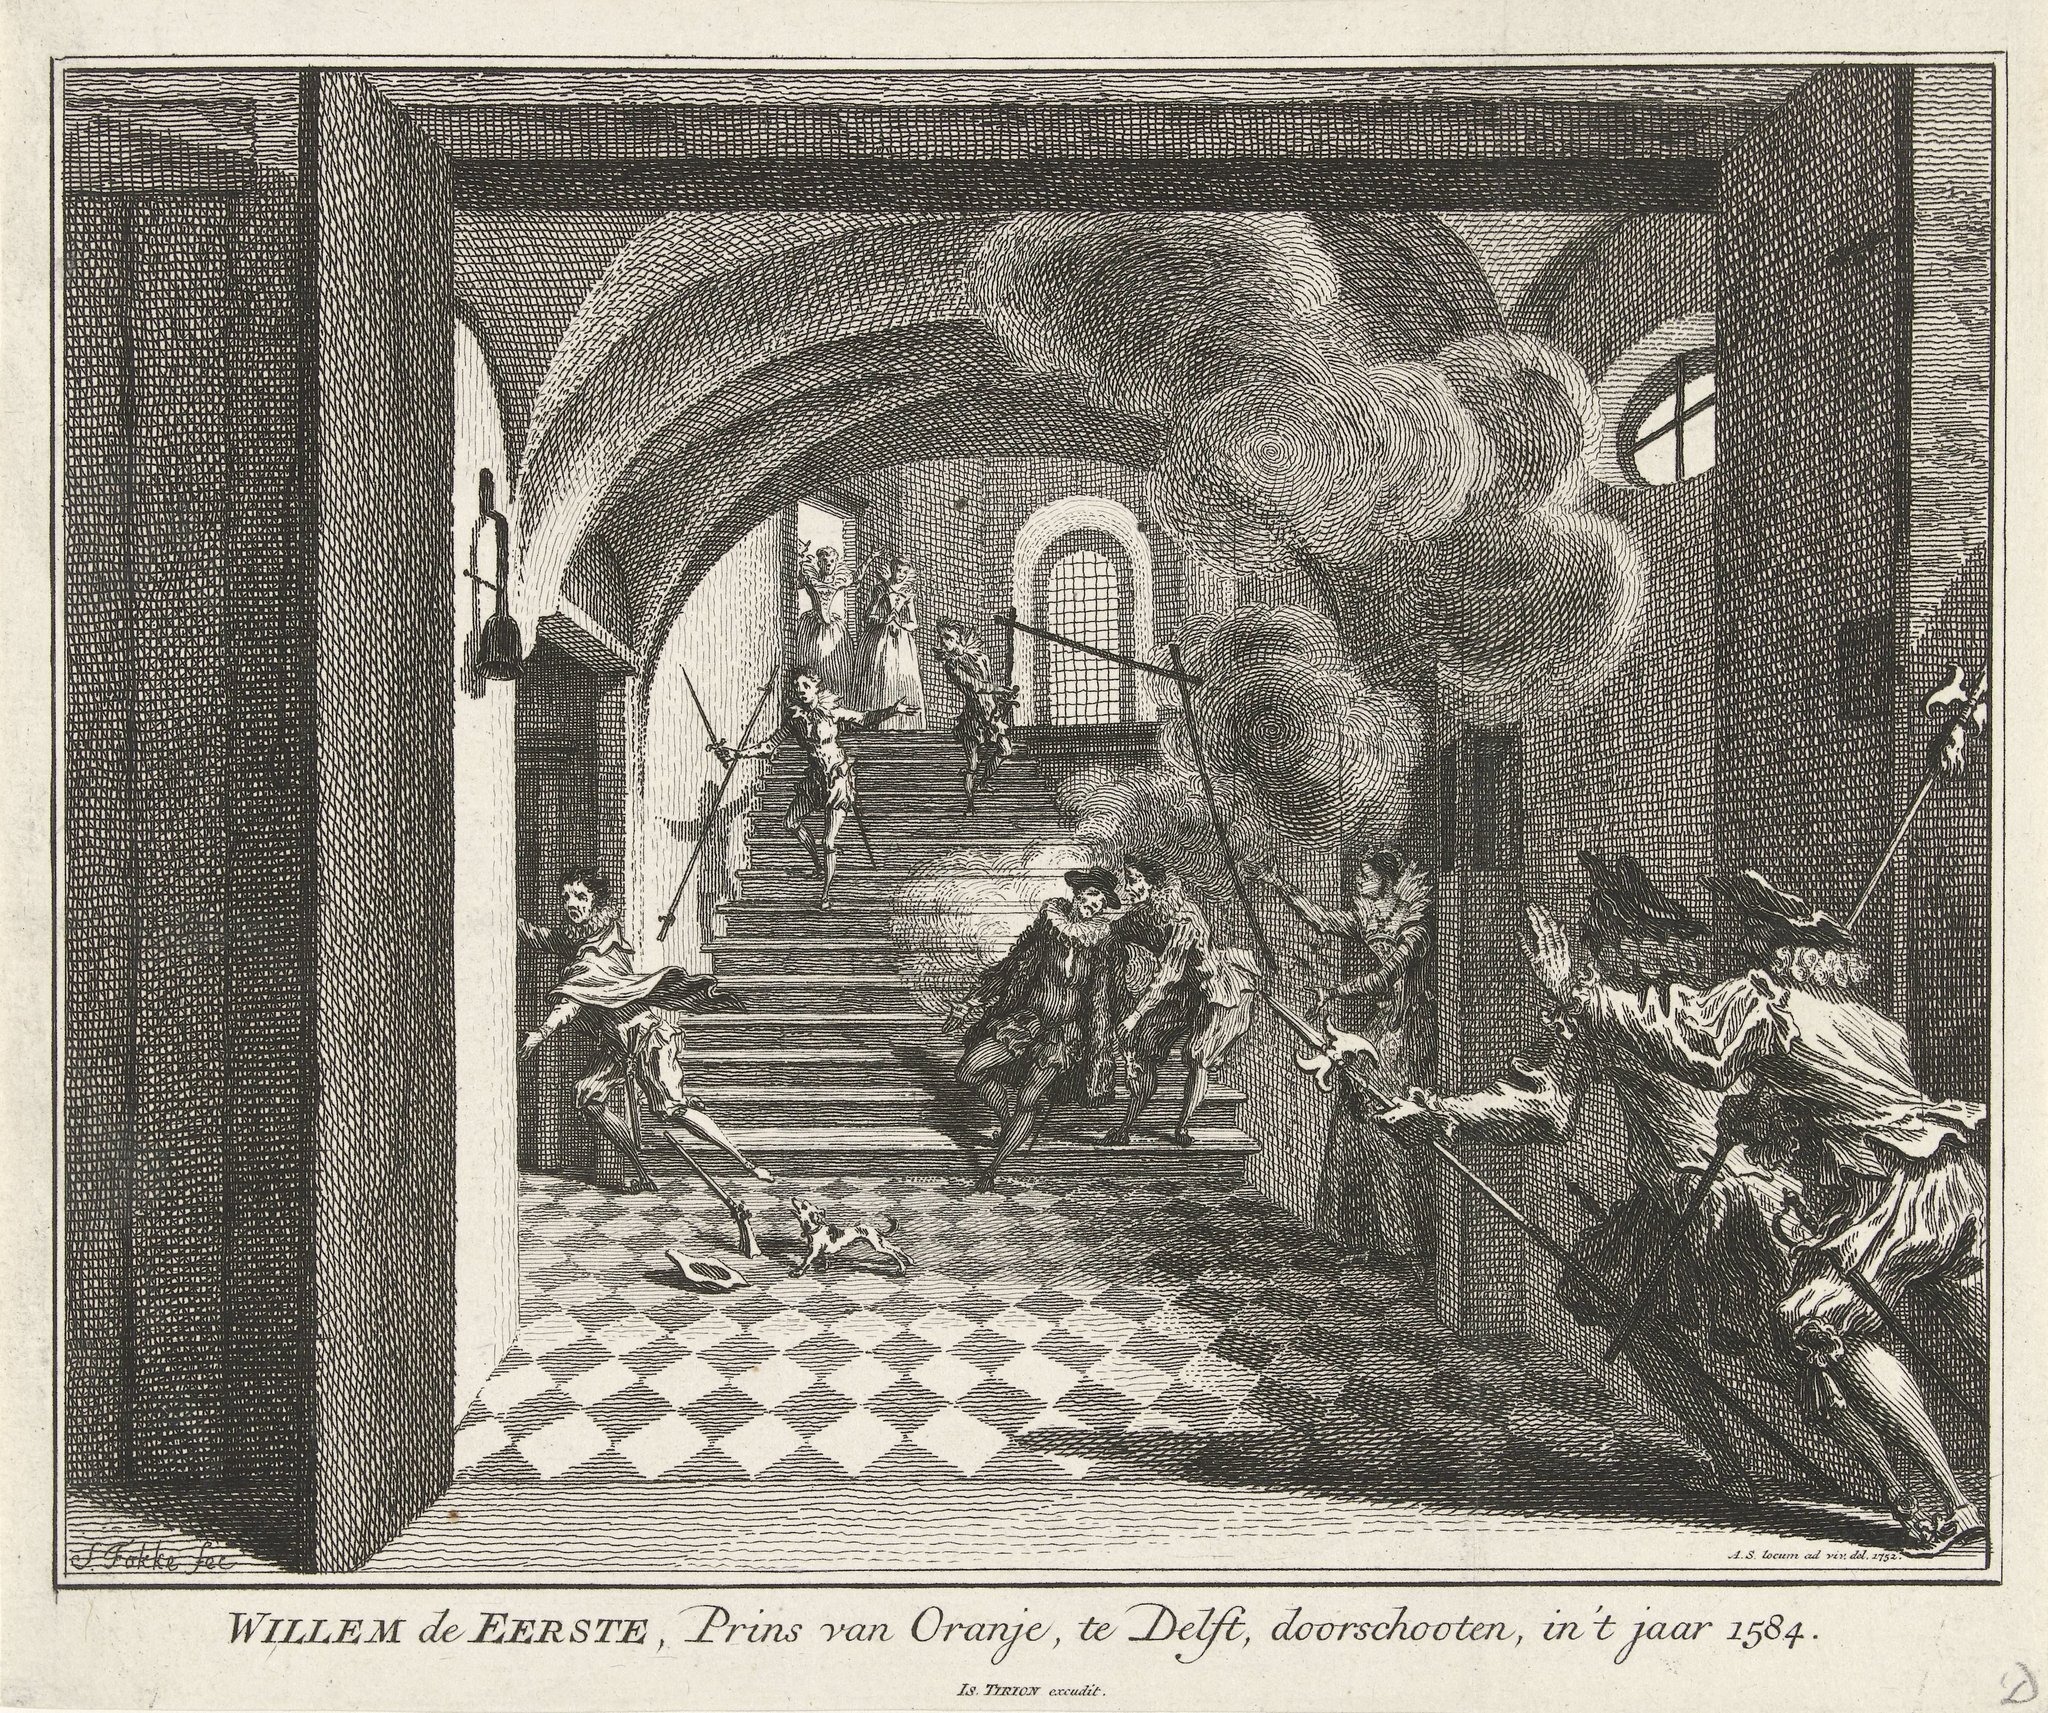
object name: print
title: Willem de Eerste, Prins van Oranje, te Delft, doorschooten, in 't jaar 1584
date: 1752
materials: paper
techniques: engraving, etching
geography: amsterdam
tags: delft, william i (prince of orange), violent death ~ elements, attempt, political murder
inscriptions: collector's mark: Lugt 2228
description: De prins van Oranje te Delft vermoord door Balthasar Gerards, 10 juli 1584. Willem van Oranje is op de trap neergeschoten en zakt in elkaar, links vlucht de moordenaar. Rechts op de voorgrond twee toesnellende wachten.